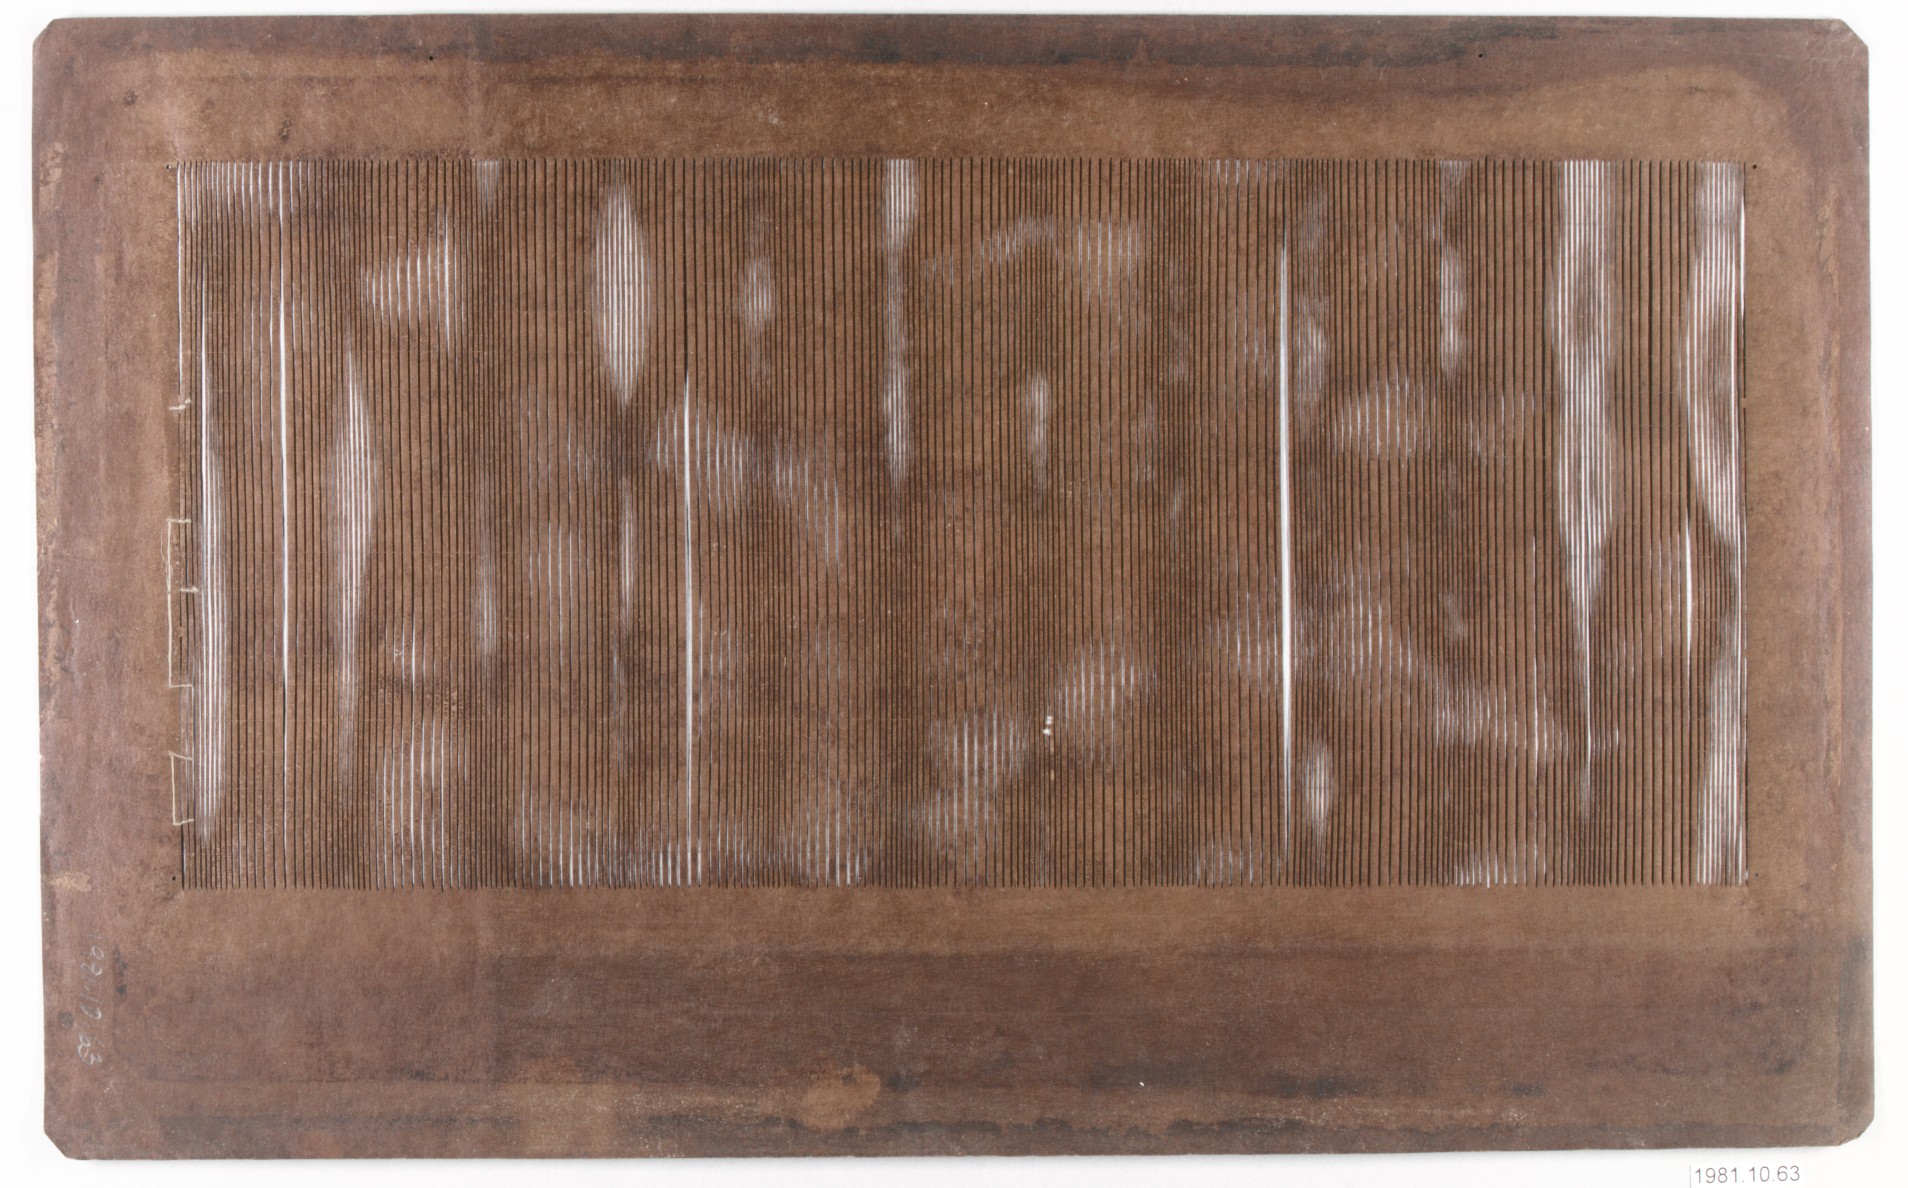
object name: stencil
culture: japanese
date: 1801-1900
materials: paper